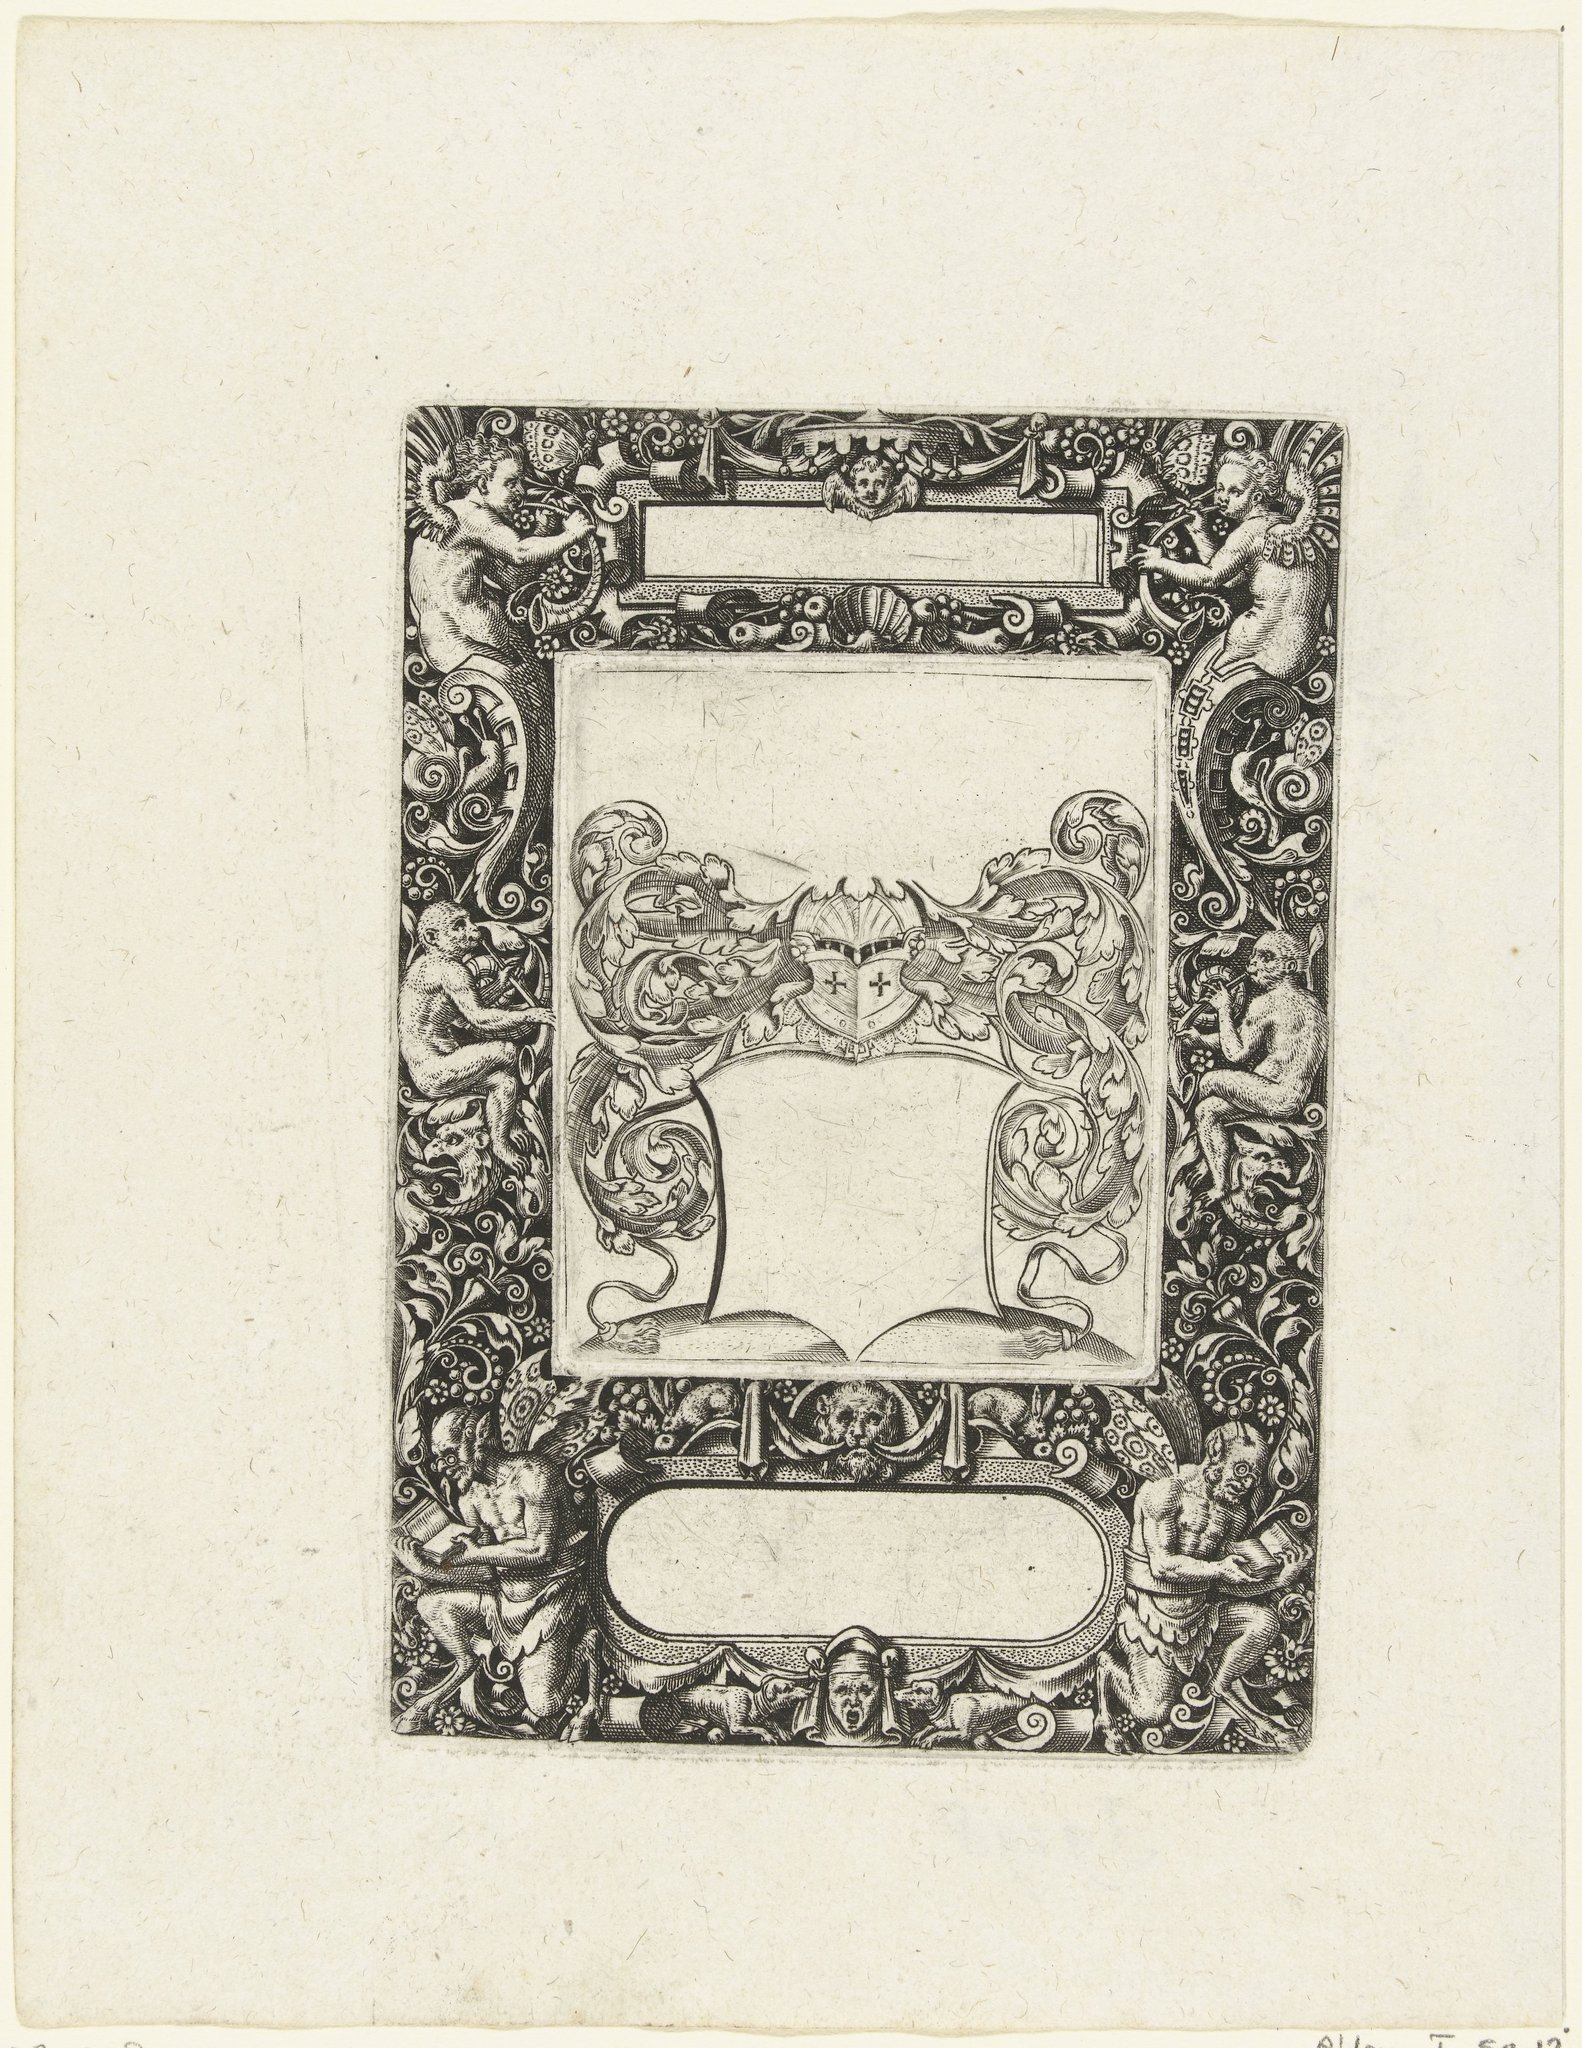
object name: ornament print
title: Emblemata Nobilitati et Vulgo scitu digna…/ Stam und Wapenbuchlein…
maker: theodor de bry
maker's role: draughtsman, print maker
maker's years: 1528-1598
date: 1593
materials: paper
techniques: engraving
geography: netherlands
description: Smalle rechthoekige cartouche middenboven en een cartouche met ronde zijkanten middenonder. Linksboven en rechtsboven rijst een trompetspelend engeltje op uit een voluut. Links- en rechtsonder leest een sater met een bril op een boek. Hoort bij een serie van 18 bladen waarbij in het midden van aparte platen zevenentwintig emblemata en vijfenveertig wapenschilden zijn gedrukt. De emblemata zijn ten dele genummerd A-D, 1-7 en 9-21. Drie bladen hebben geen nummer. De wapenschilden, die deels dubbel zijn afgedrukt, zijn ongenummerd.